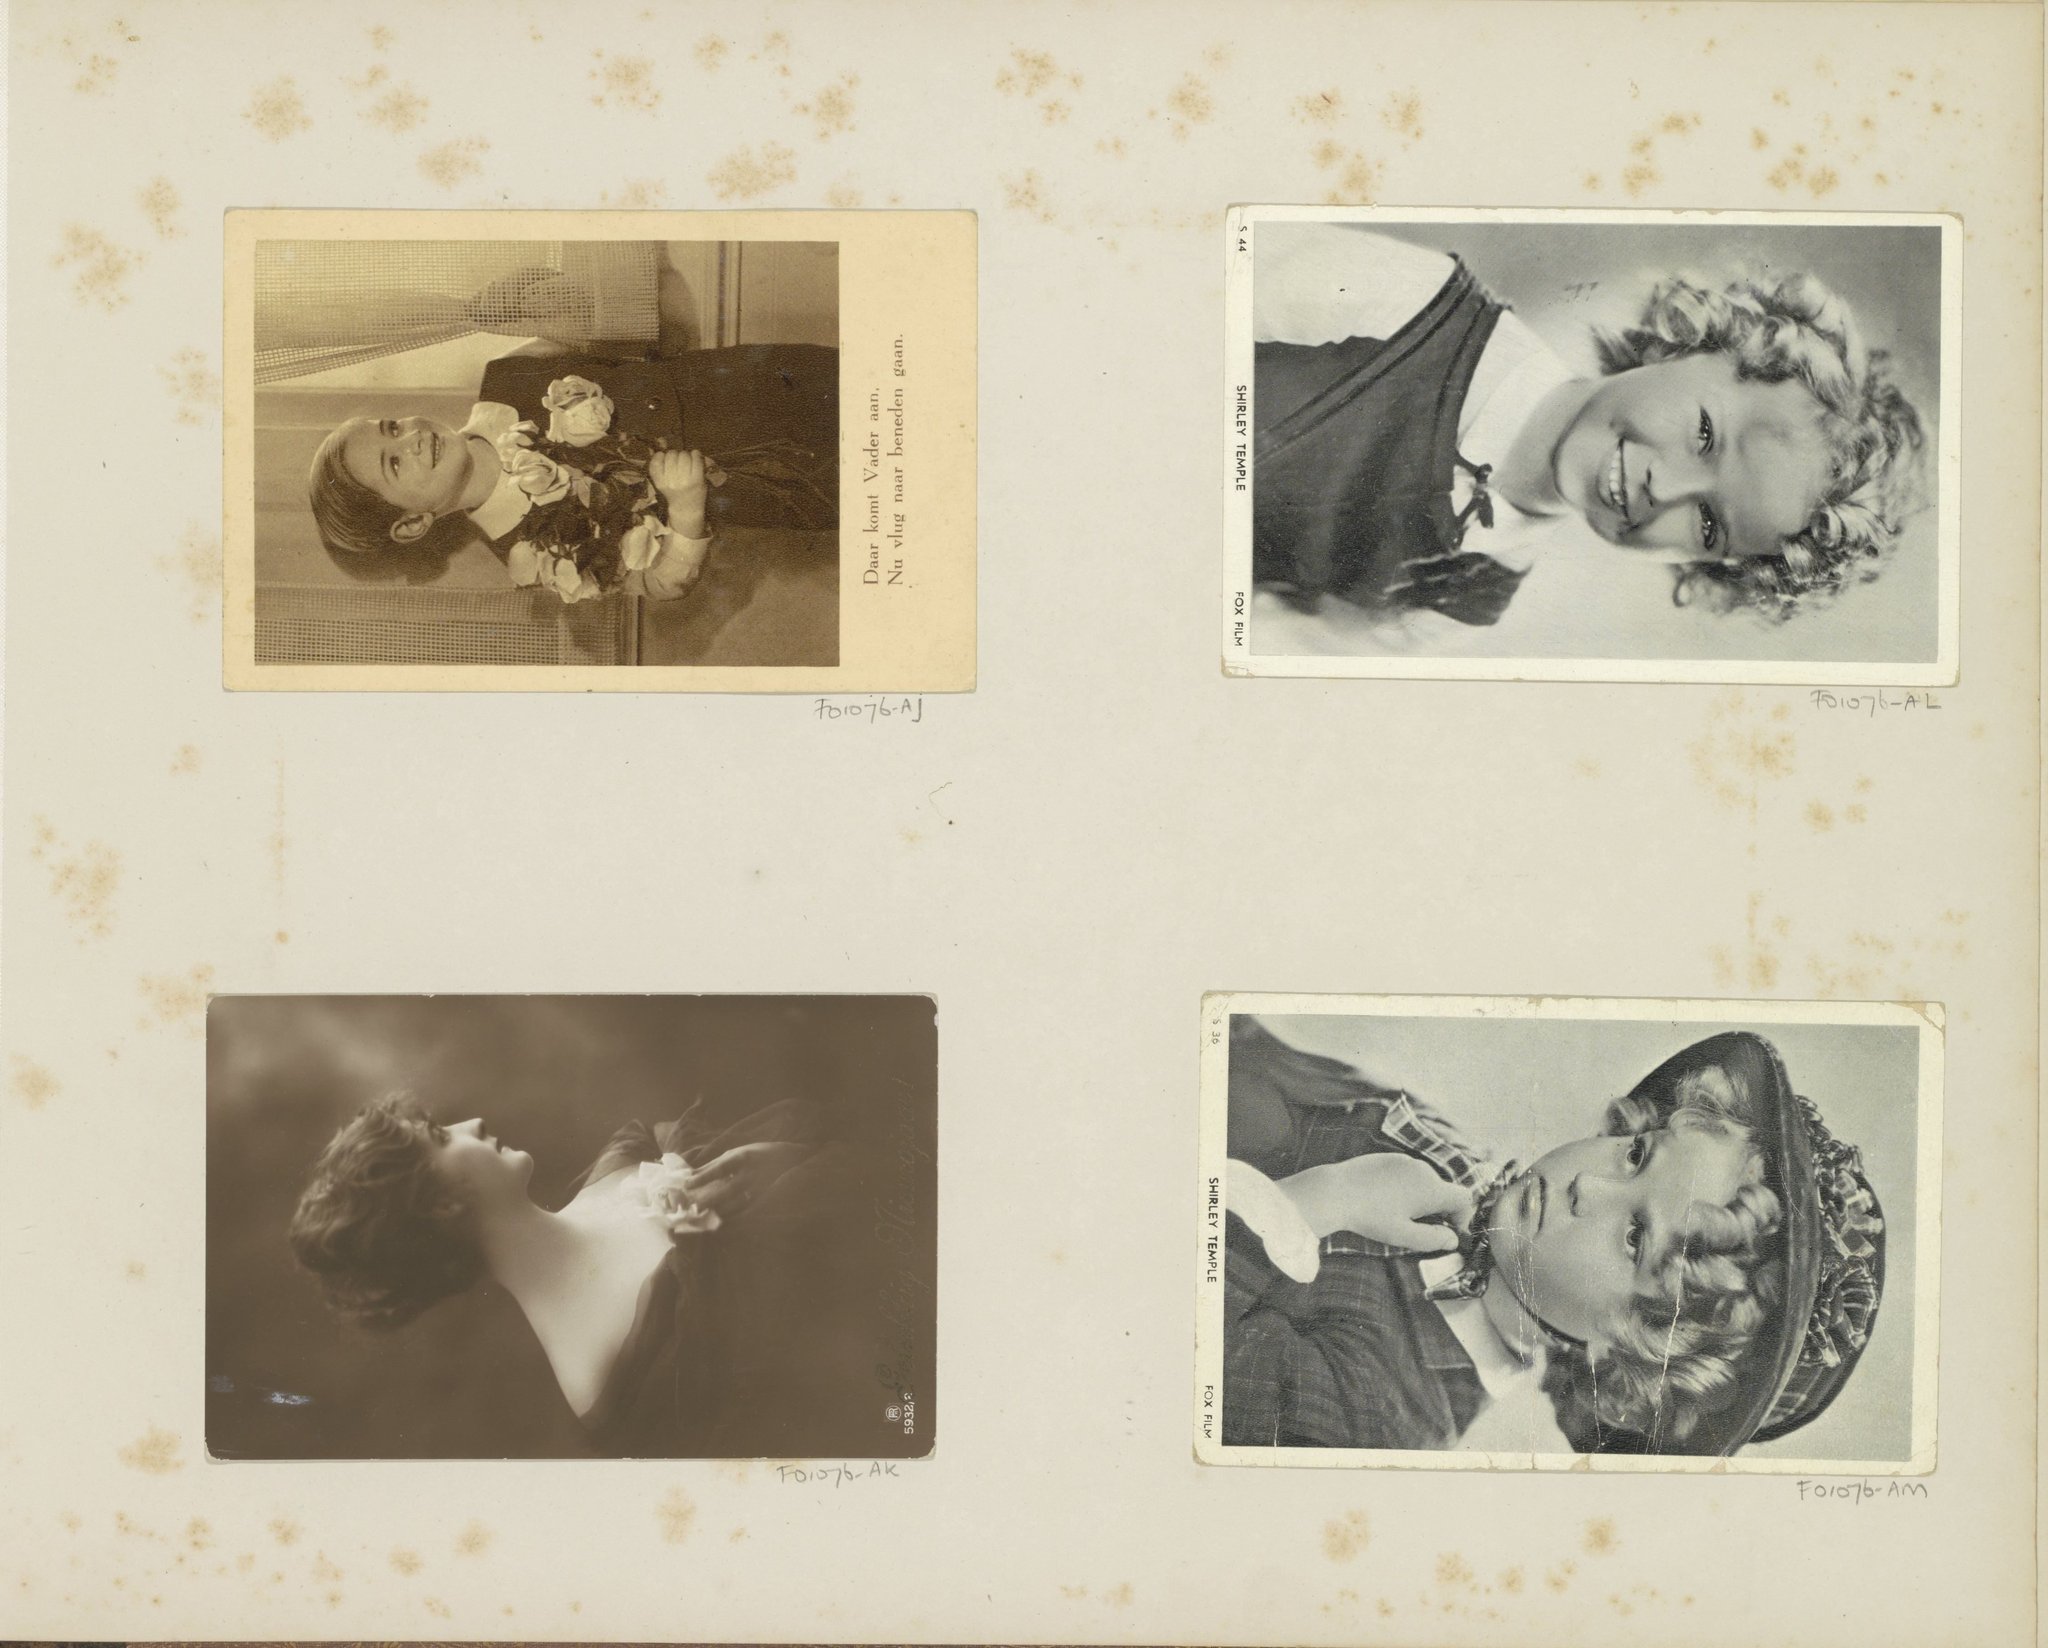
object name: album leaf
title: Portret van Shirley Temple als kind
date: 1930-1940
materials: cardboard, paper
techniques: rotogravure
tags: child, portrait of actor, actress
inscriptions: number: ‘S 44’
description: Onderdeel van Album met foto's van spoorwegen in Nederlands-Indië en prentbriefkaarten.